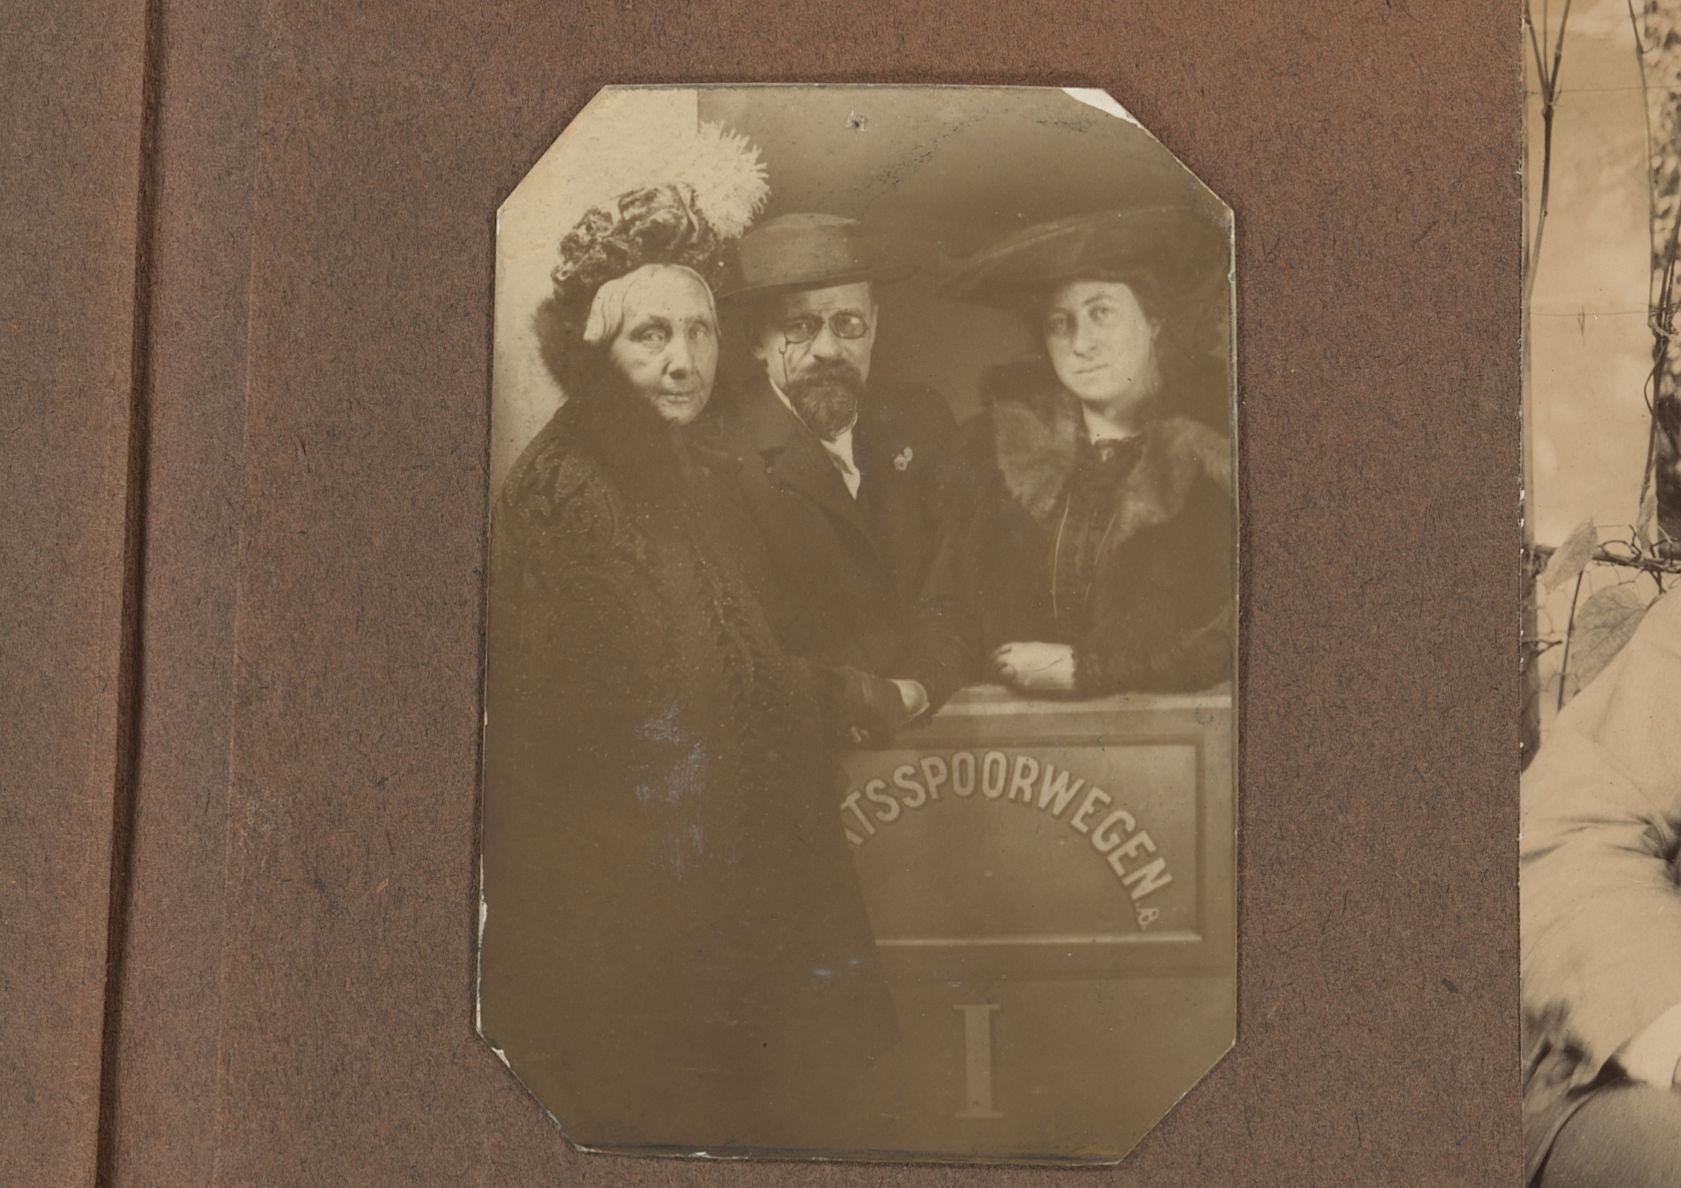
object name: photograph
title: Twee vrouwen en een man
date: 1870-1920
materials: photographic support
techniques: cutting, photography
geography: amsterdam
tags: netherlands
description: Foto op bruin albumblad 35 van familiealbum van Alphons Diepenbrock.